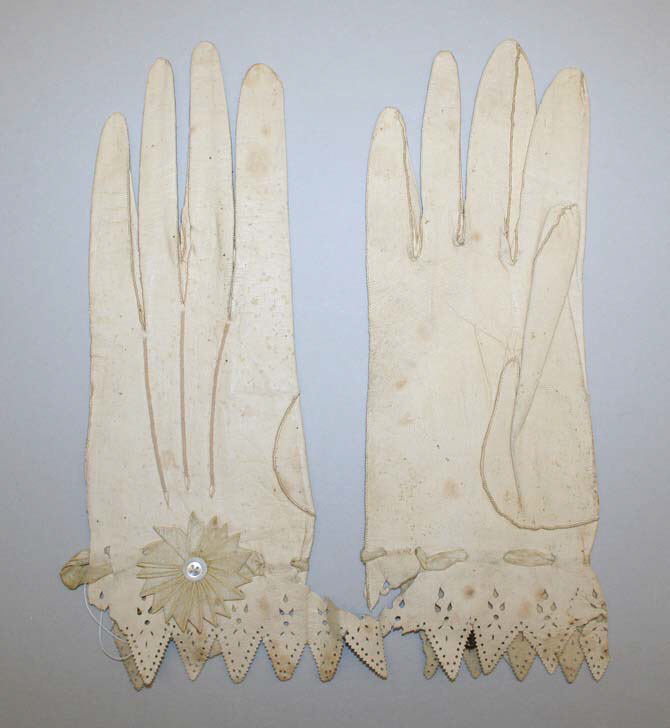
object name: glove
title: Gloves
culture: american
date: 1876-1900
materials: leather, silk